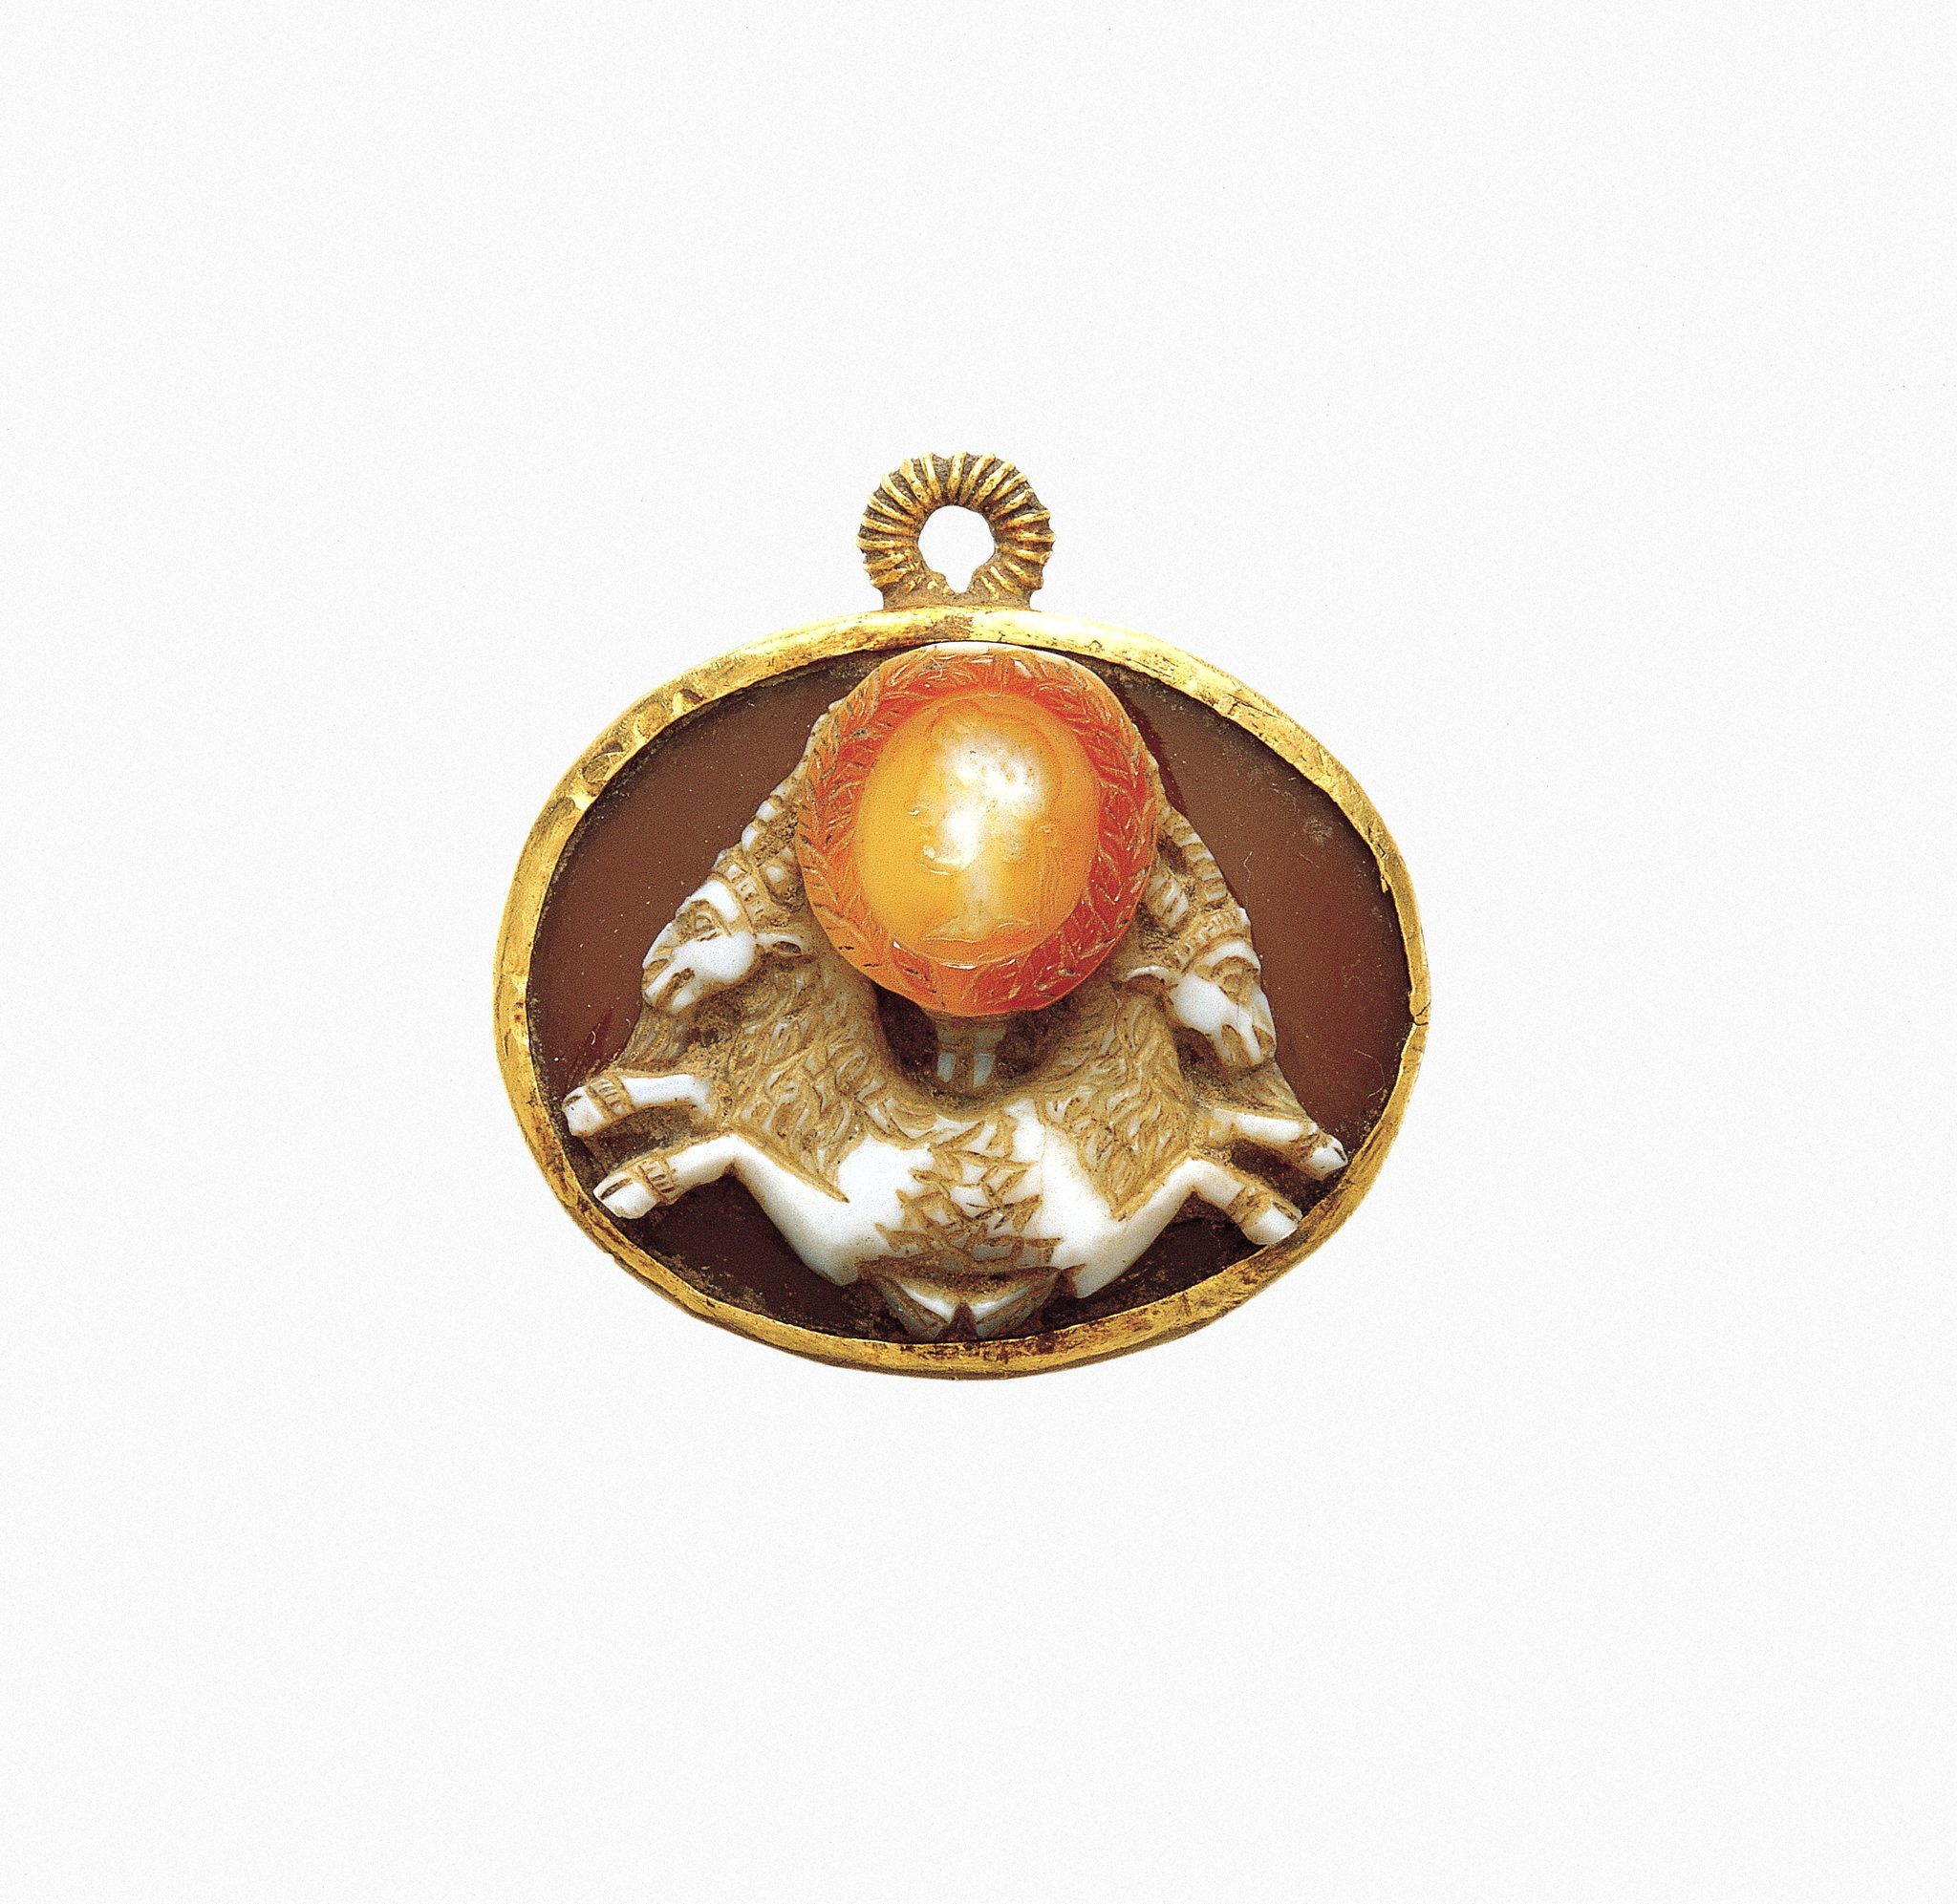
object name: cameo, portrait of augustus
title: Sardonyx cameo of a double capricorn with a portrait of the emperor Augustus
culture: roman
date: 27 BCE-14 CE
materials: gold, gemstone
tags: emperor augustus,goats